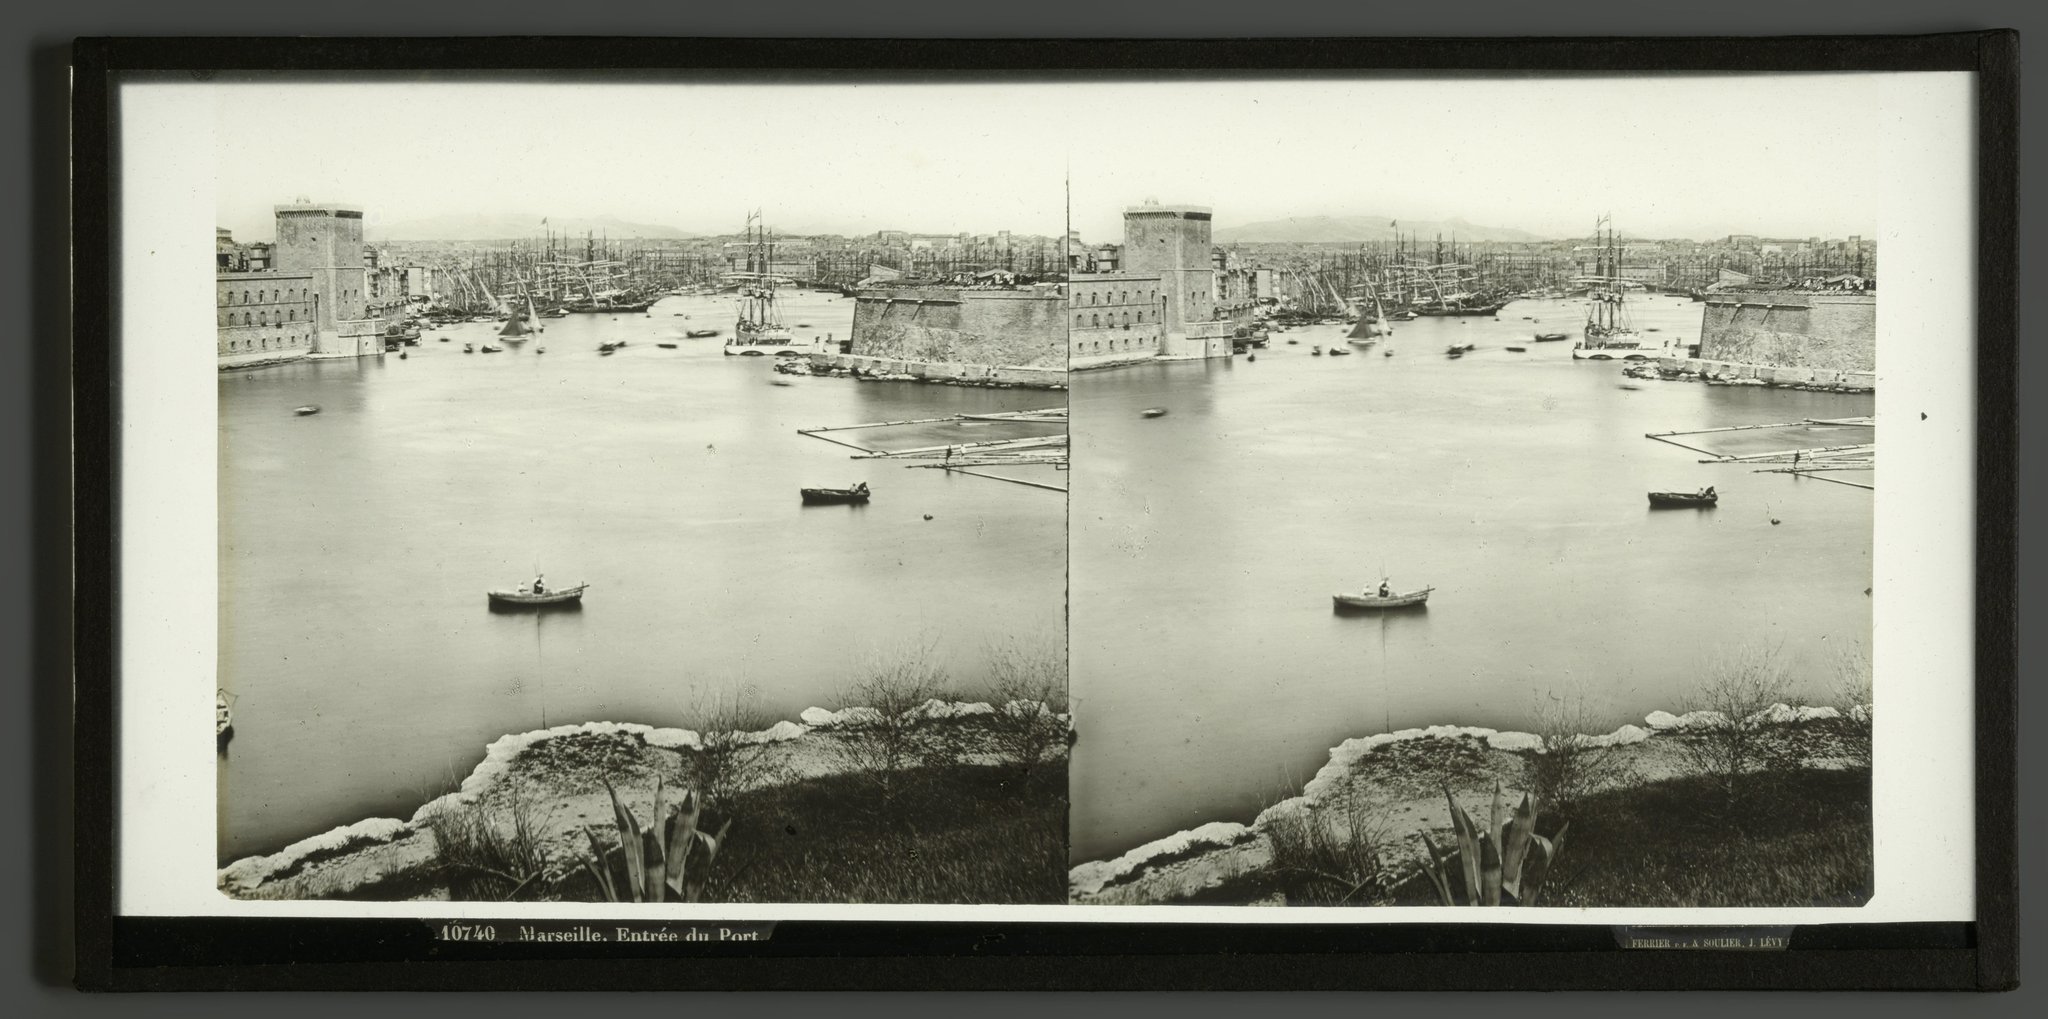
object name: stereoscopic photograph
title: Gezicht op de haven van Marseille, Frankrijk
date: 1860-1870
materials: glass, paper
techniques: slide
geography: marseille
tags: harbour, canals, waters (in city), prospect of city, town panorama, silhouette of city, marseille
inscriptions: number: ‘10740’